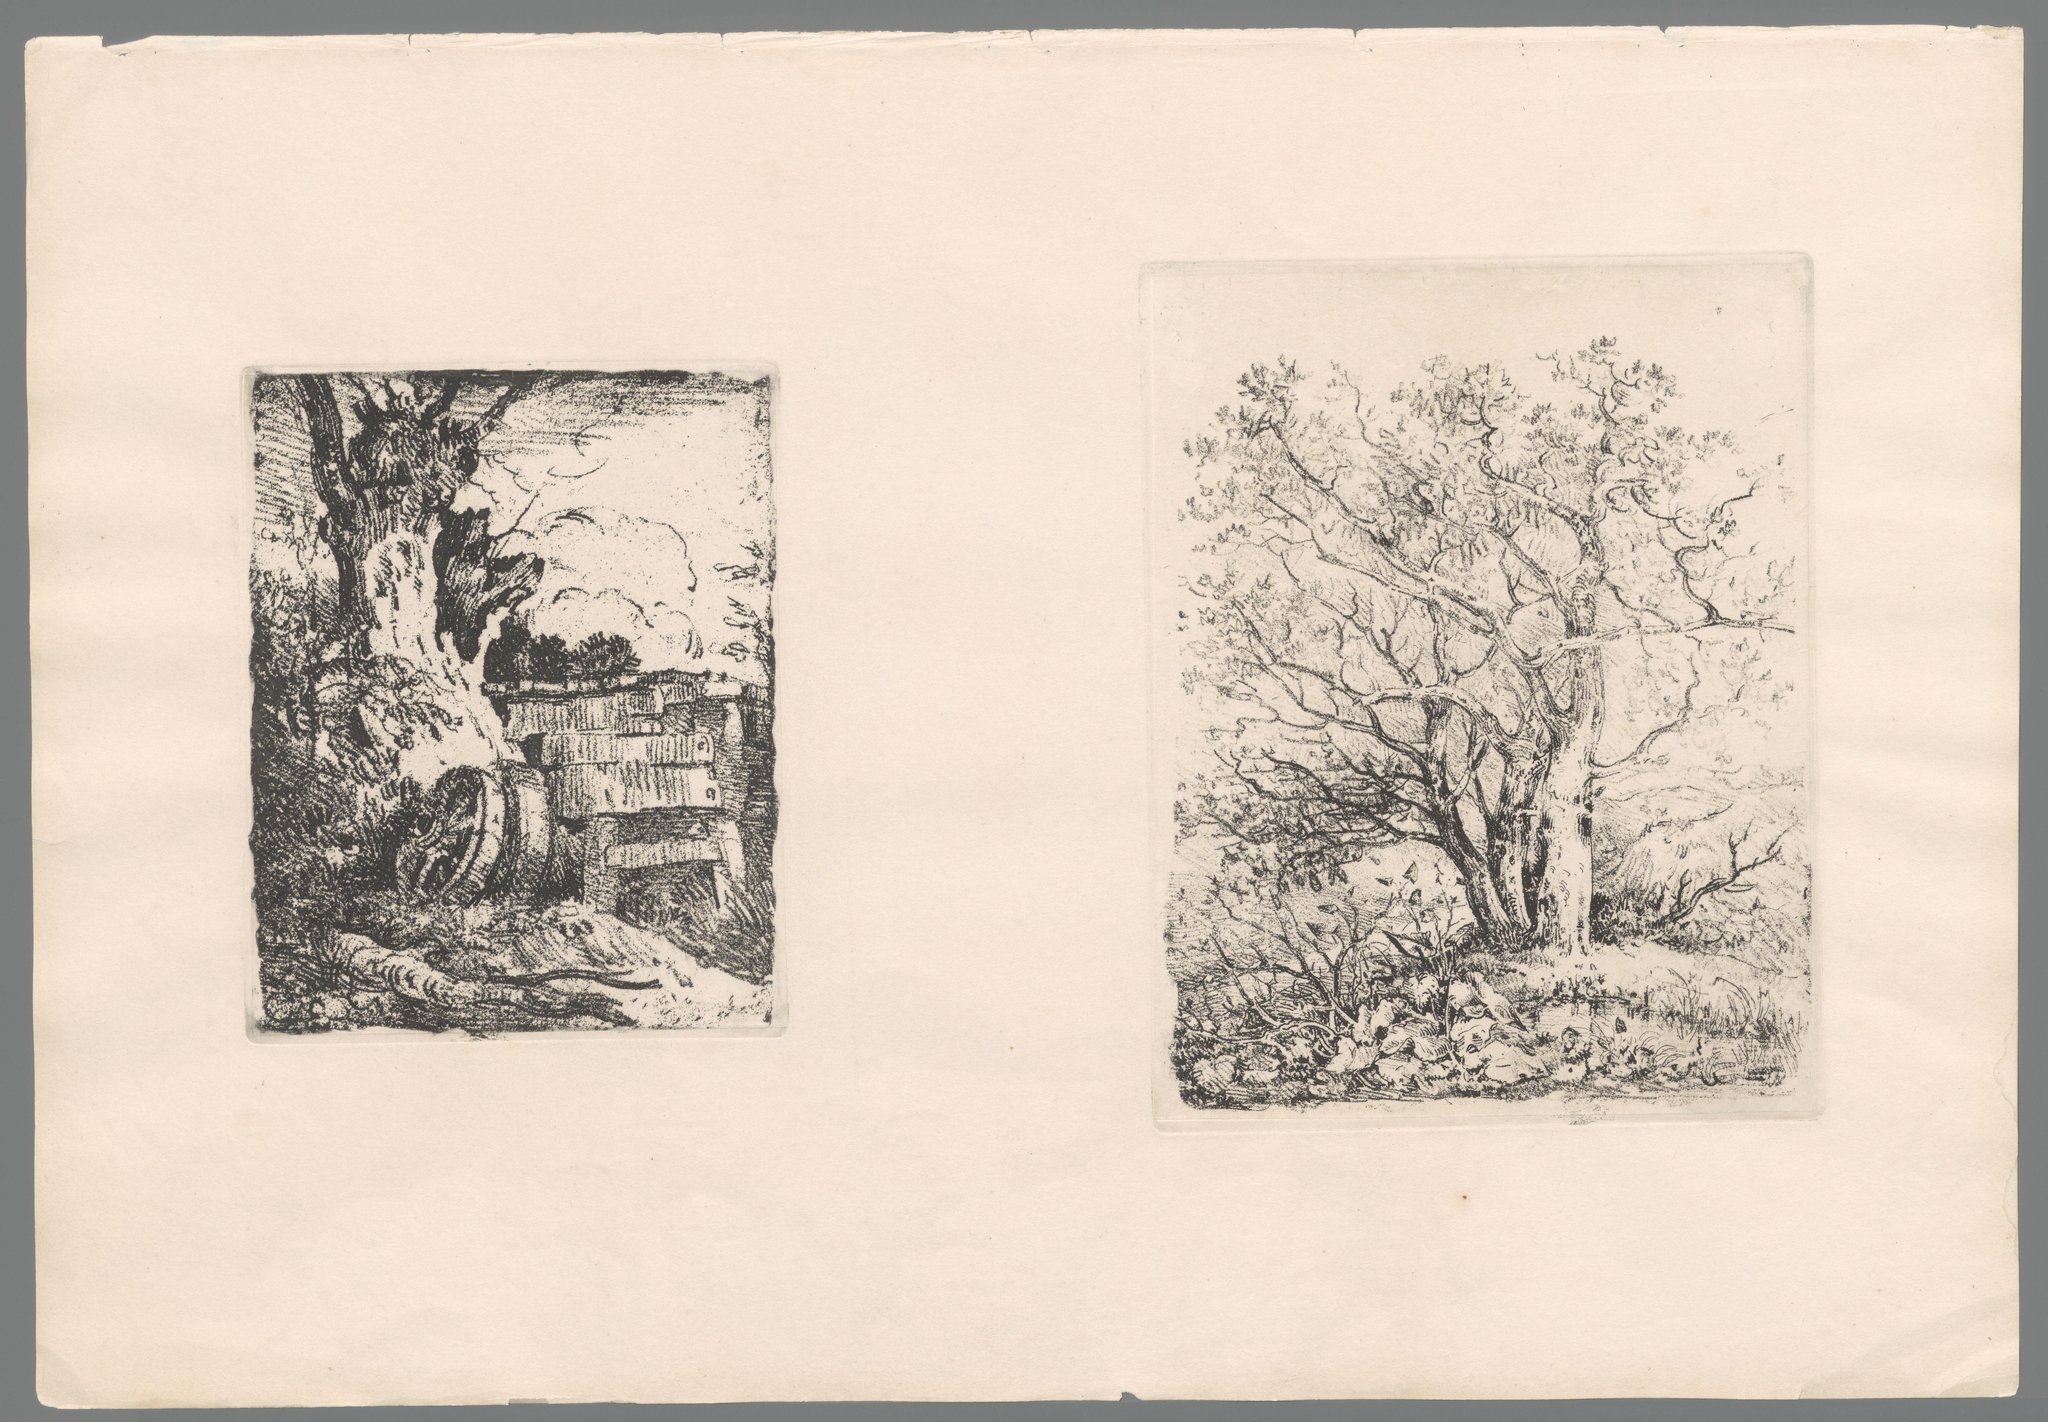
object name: print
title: Norfolk Picturesque Scenery (...) thirty-one etchings, by the late John Crome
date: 1834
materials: paper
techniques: soft ground etching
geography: norwich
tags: trees, road, path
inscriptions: collector's mark: Lugt 2228, collector's mark: Lugt 2760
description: Prent staat samen met RP-P-1973-193 op een onversneden blad.